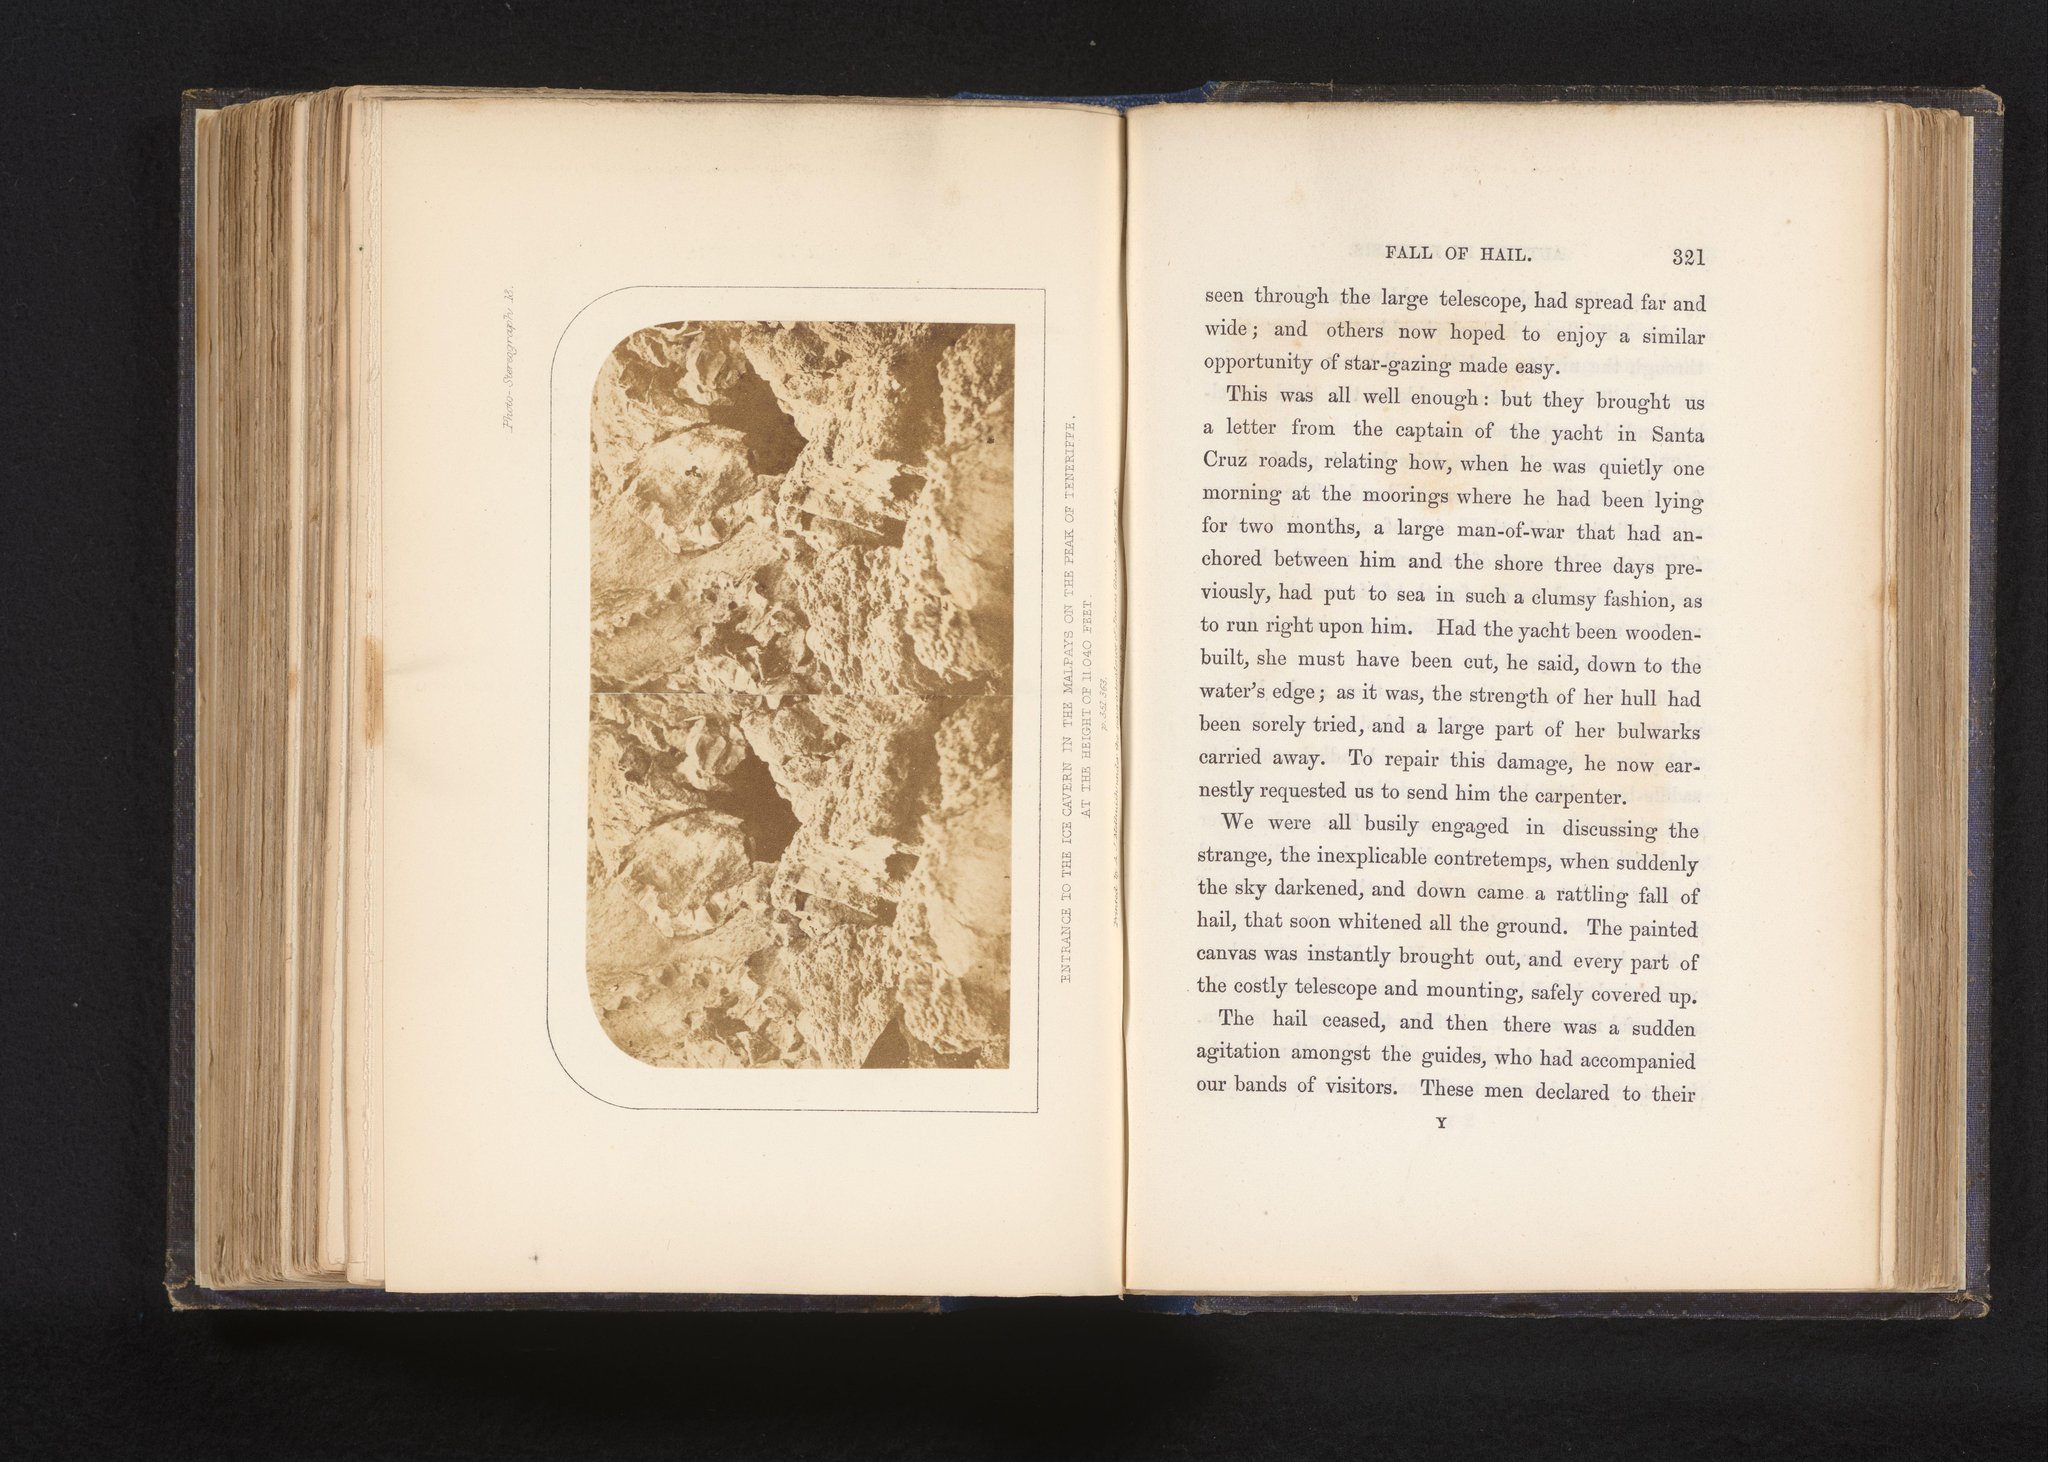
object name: page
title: Entrance to the ice cavern, in the malpays of the Peak of Teneriffe, at the height of 11,040 feet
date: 1856-1858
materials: paper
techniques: albumen print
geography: london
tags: cave, grotto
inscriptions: inscription: ‘Photo-Stereograph 13.’